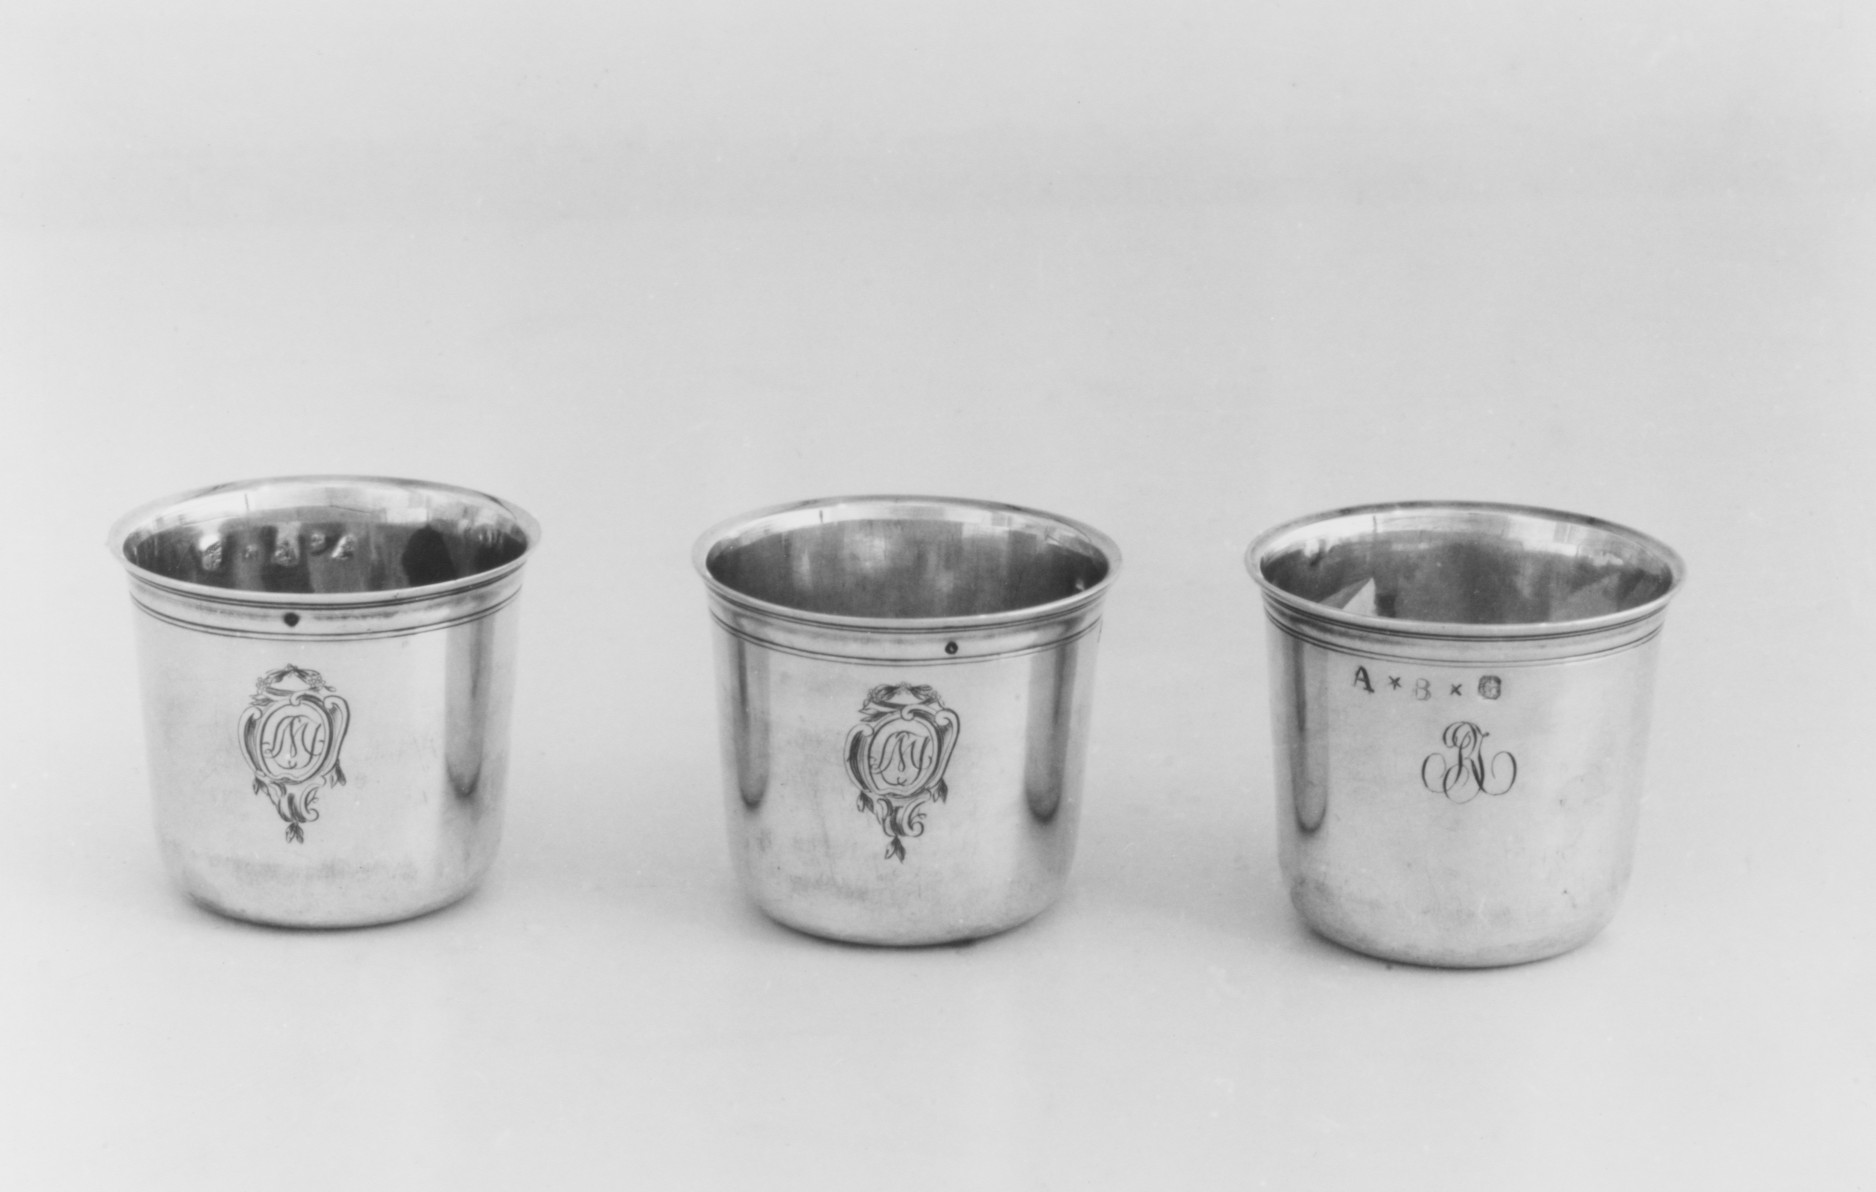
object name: liqueur cup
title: Set of six liqueur cups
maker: jacques charles chambert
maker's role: maker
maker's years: 1730-1818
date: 1780-1781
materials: silver